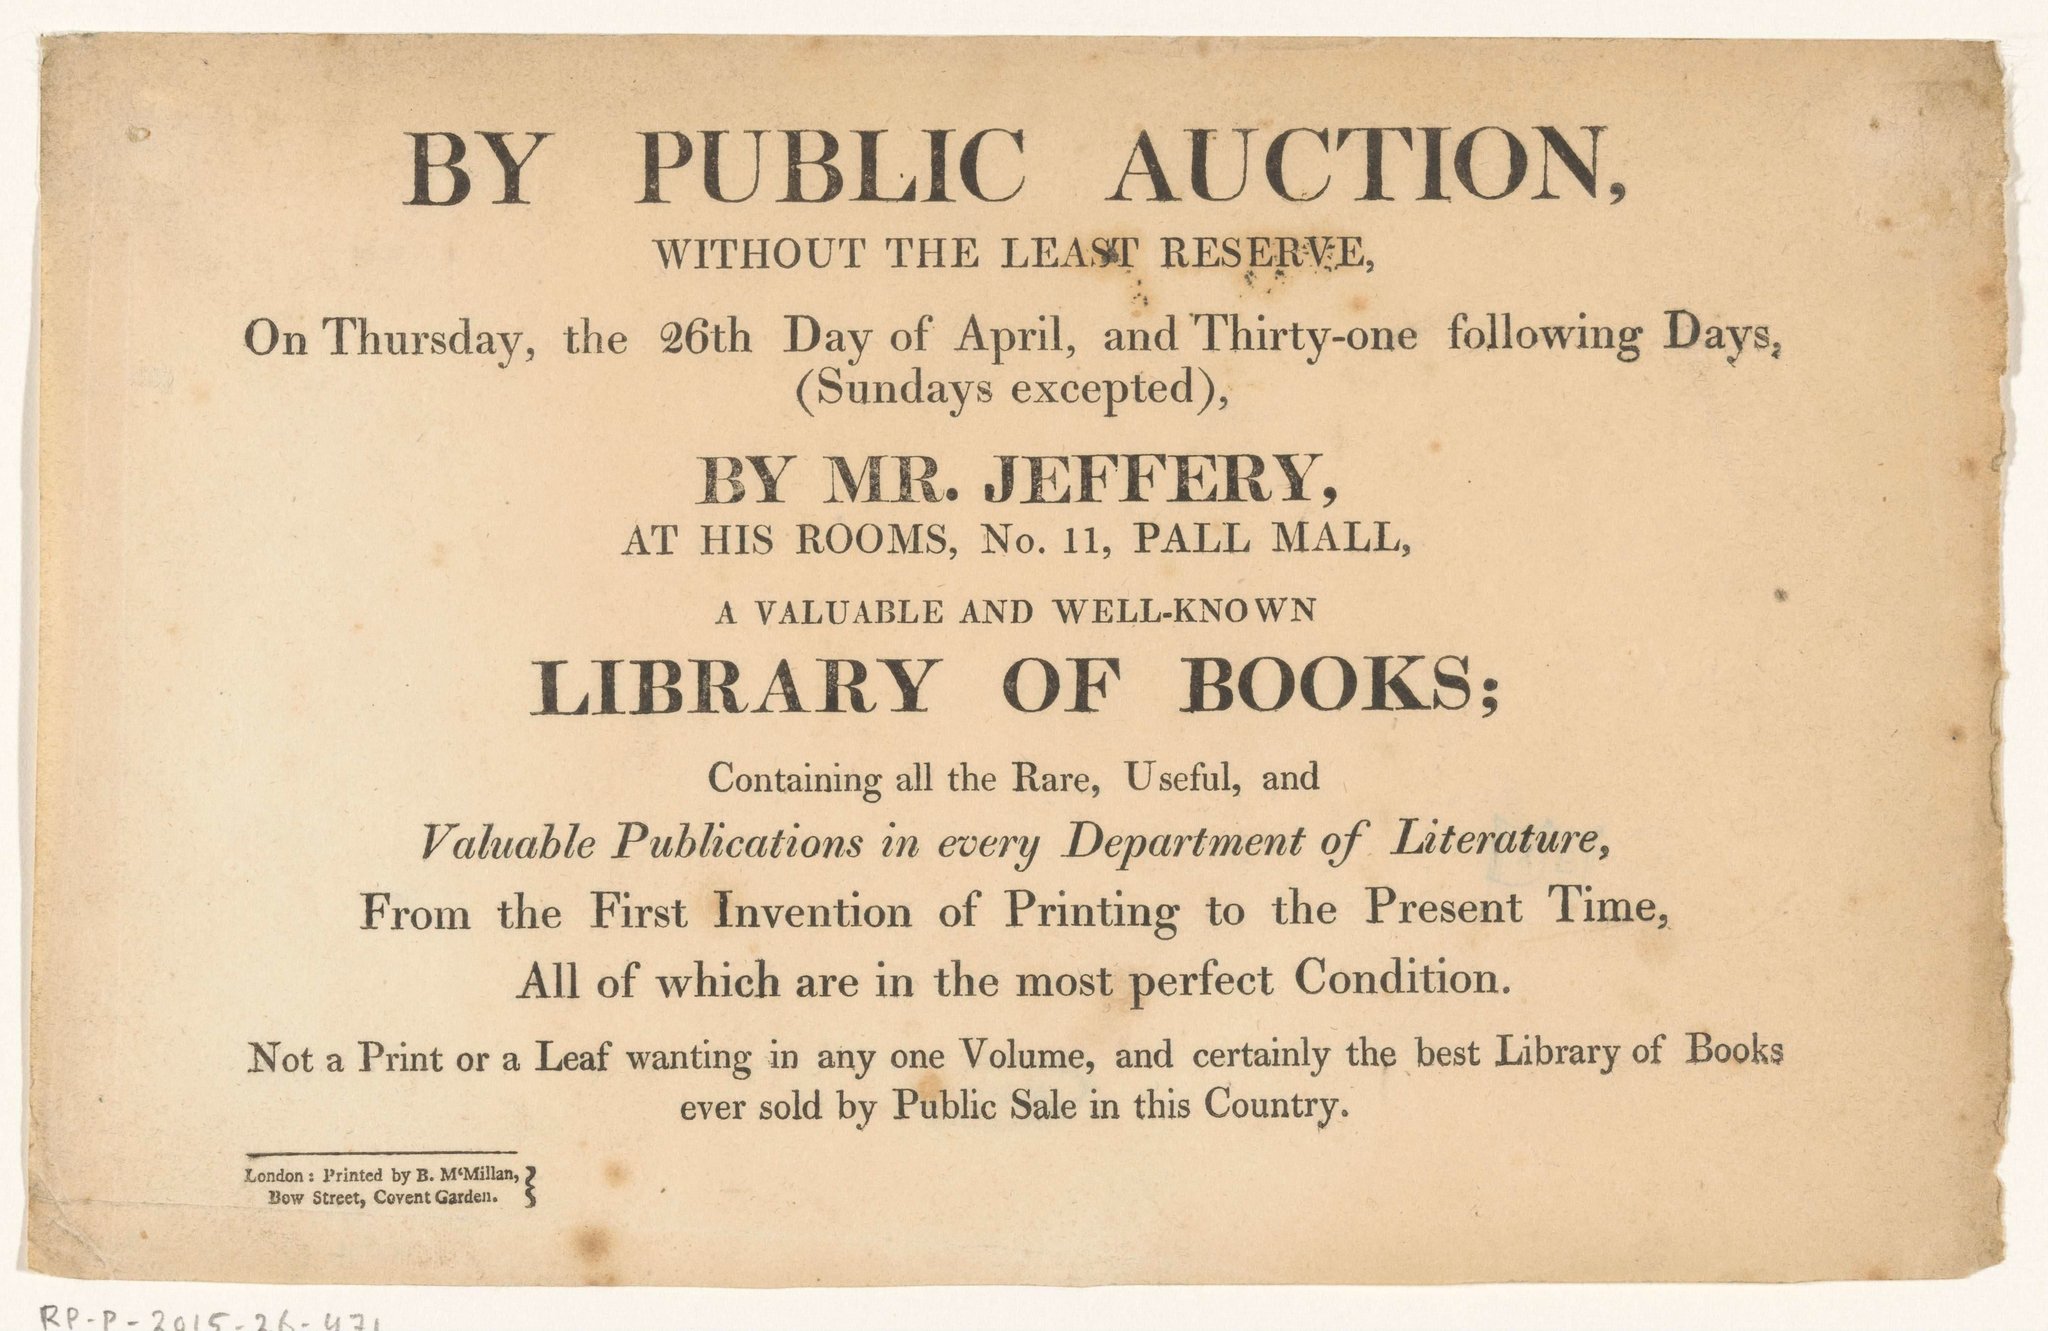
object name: print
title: Aankondiging van een boekenveiling, gehouden door Edward Jeffrey te Londen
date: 1810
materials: paper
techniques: letterpress printing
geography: london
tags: art sale, auction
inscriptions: collector's mark: Lugt 4779, collector's mark: Lugt 2228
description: Aankondiging van de veiling van de Bibliotheca Heathiana, waarvan de kern werd gevormd door de verzameling van Benjamin Heath (1704-1766). De veiling begon op 26 april 1810 duurde 31 dagen. Zie: List of Catalogues of English Book Sales 1676-1900 now in the British Museum. Londen: British Museum, p. 125.